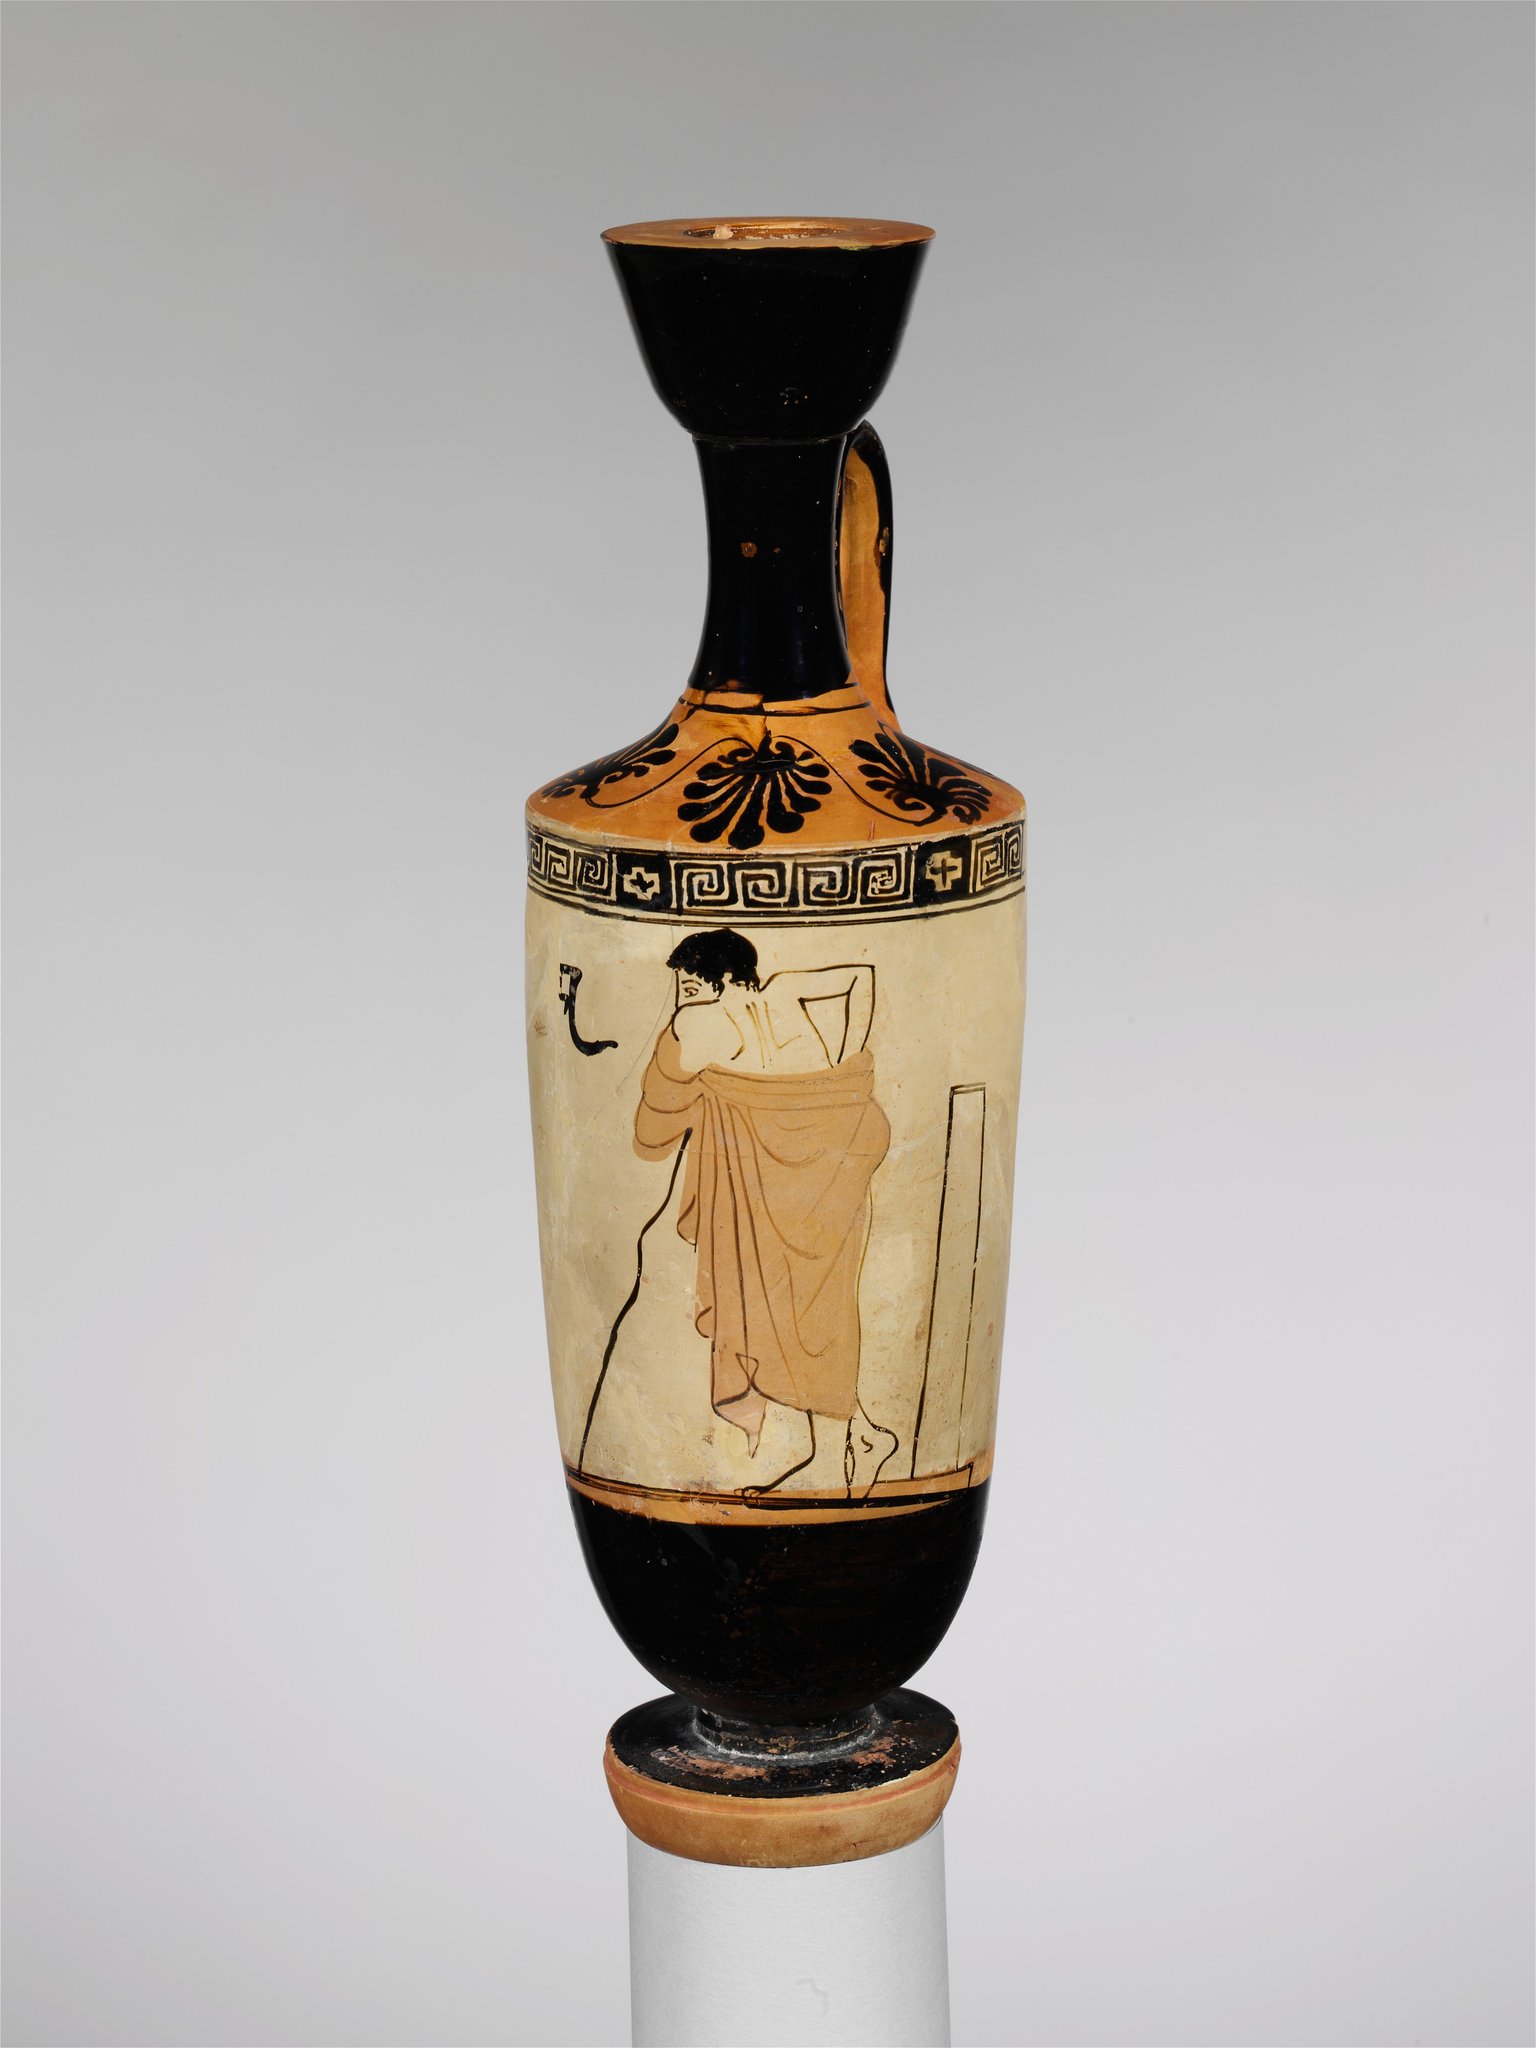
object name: lekythos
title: Terracotta lekythos (oil flask)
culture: greek, attic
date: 500-476 BCE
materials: terracotta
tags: palmettes,men